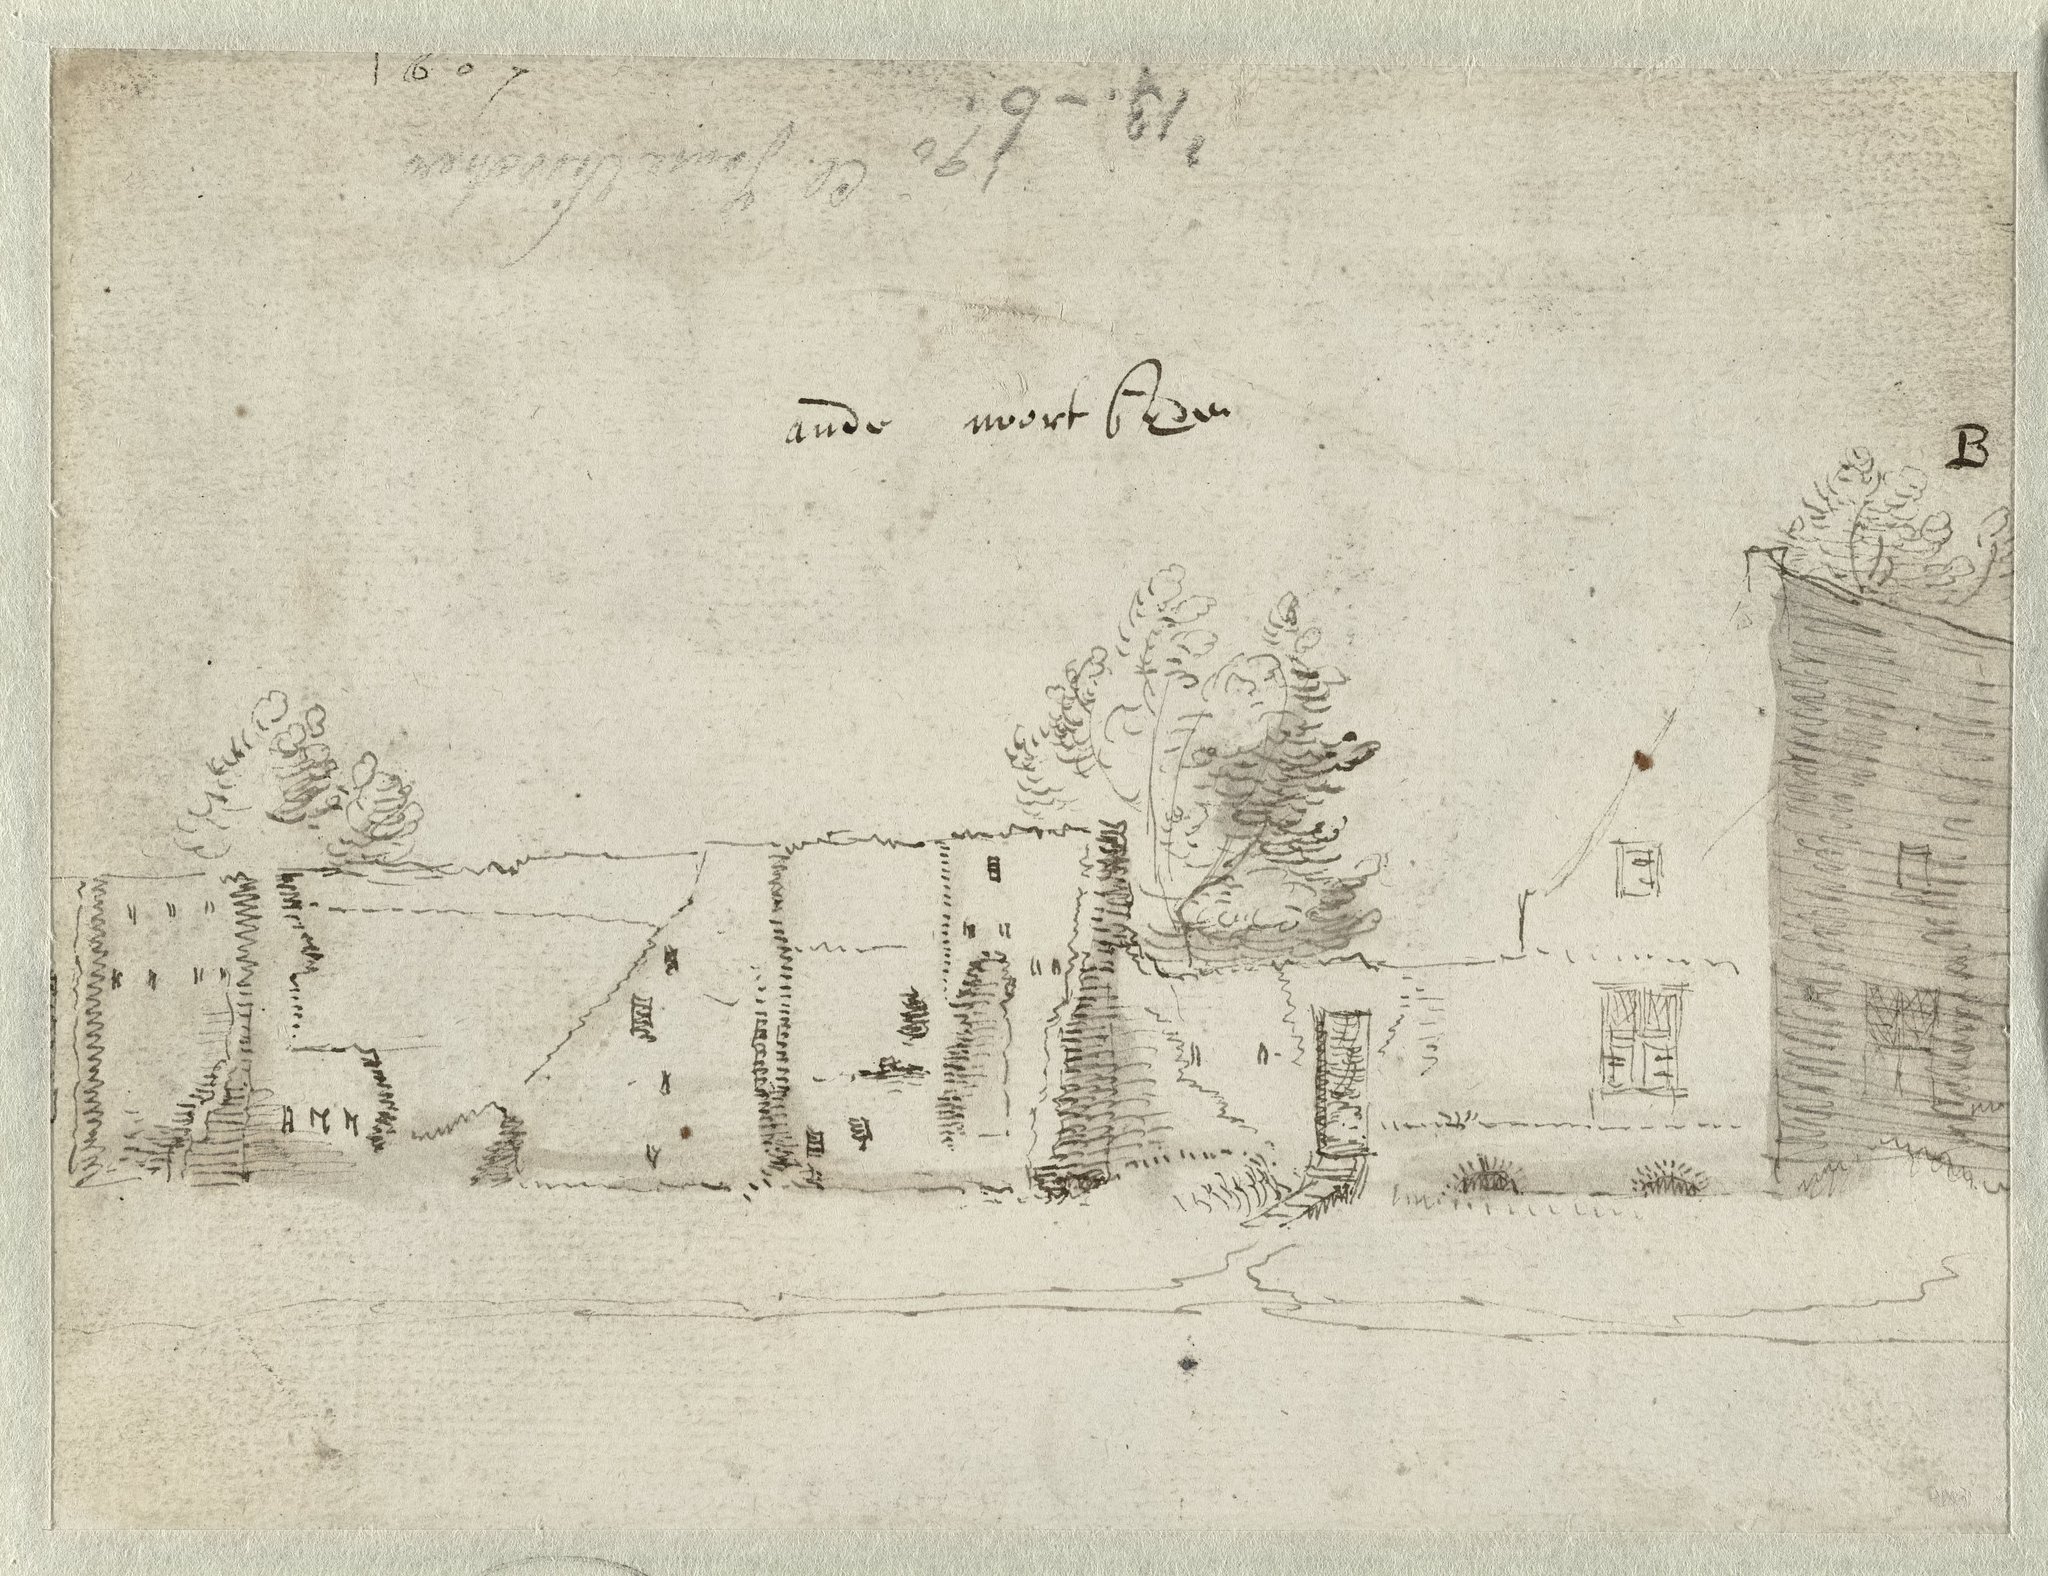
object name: drawing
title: Ruïne van een muur achter een huis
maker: claes jansz. visscher (ii)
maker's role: draughtsman, print maker, publisher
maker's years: 1586-1652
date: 1607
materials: ink, paper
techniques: brush, pen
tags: ruin of a building ~ architecture